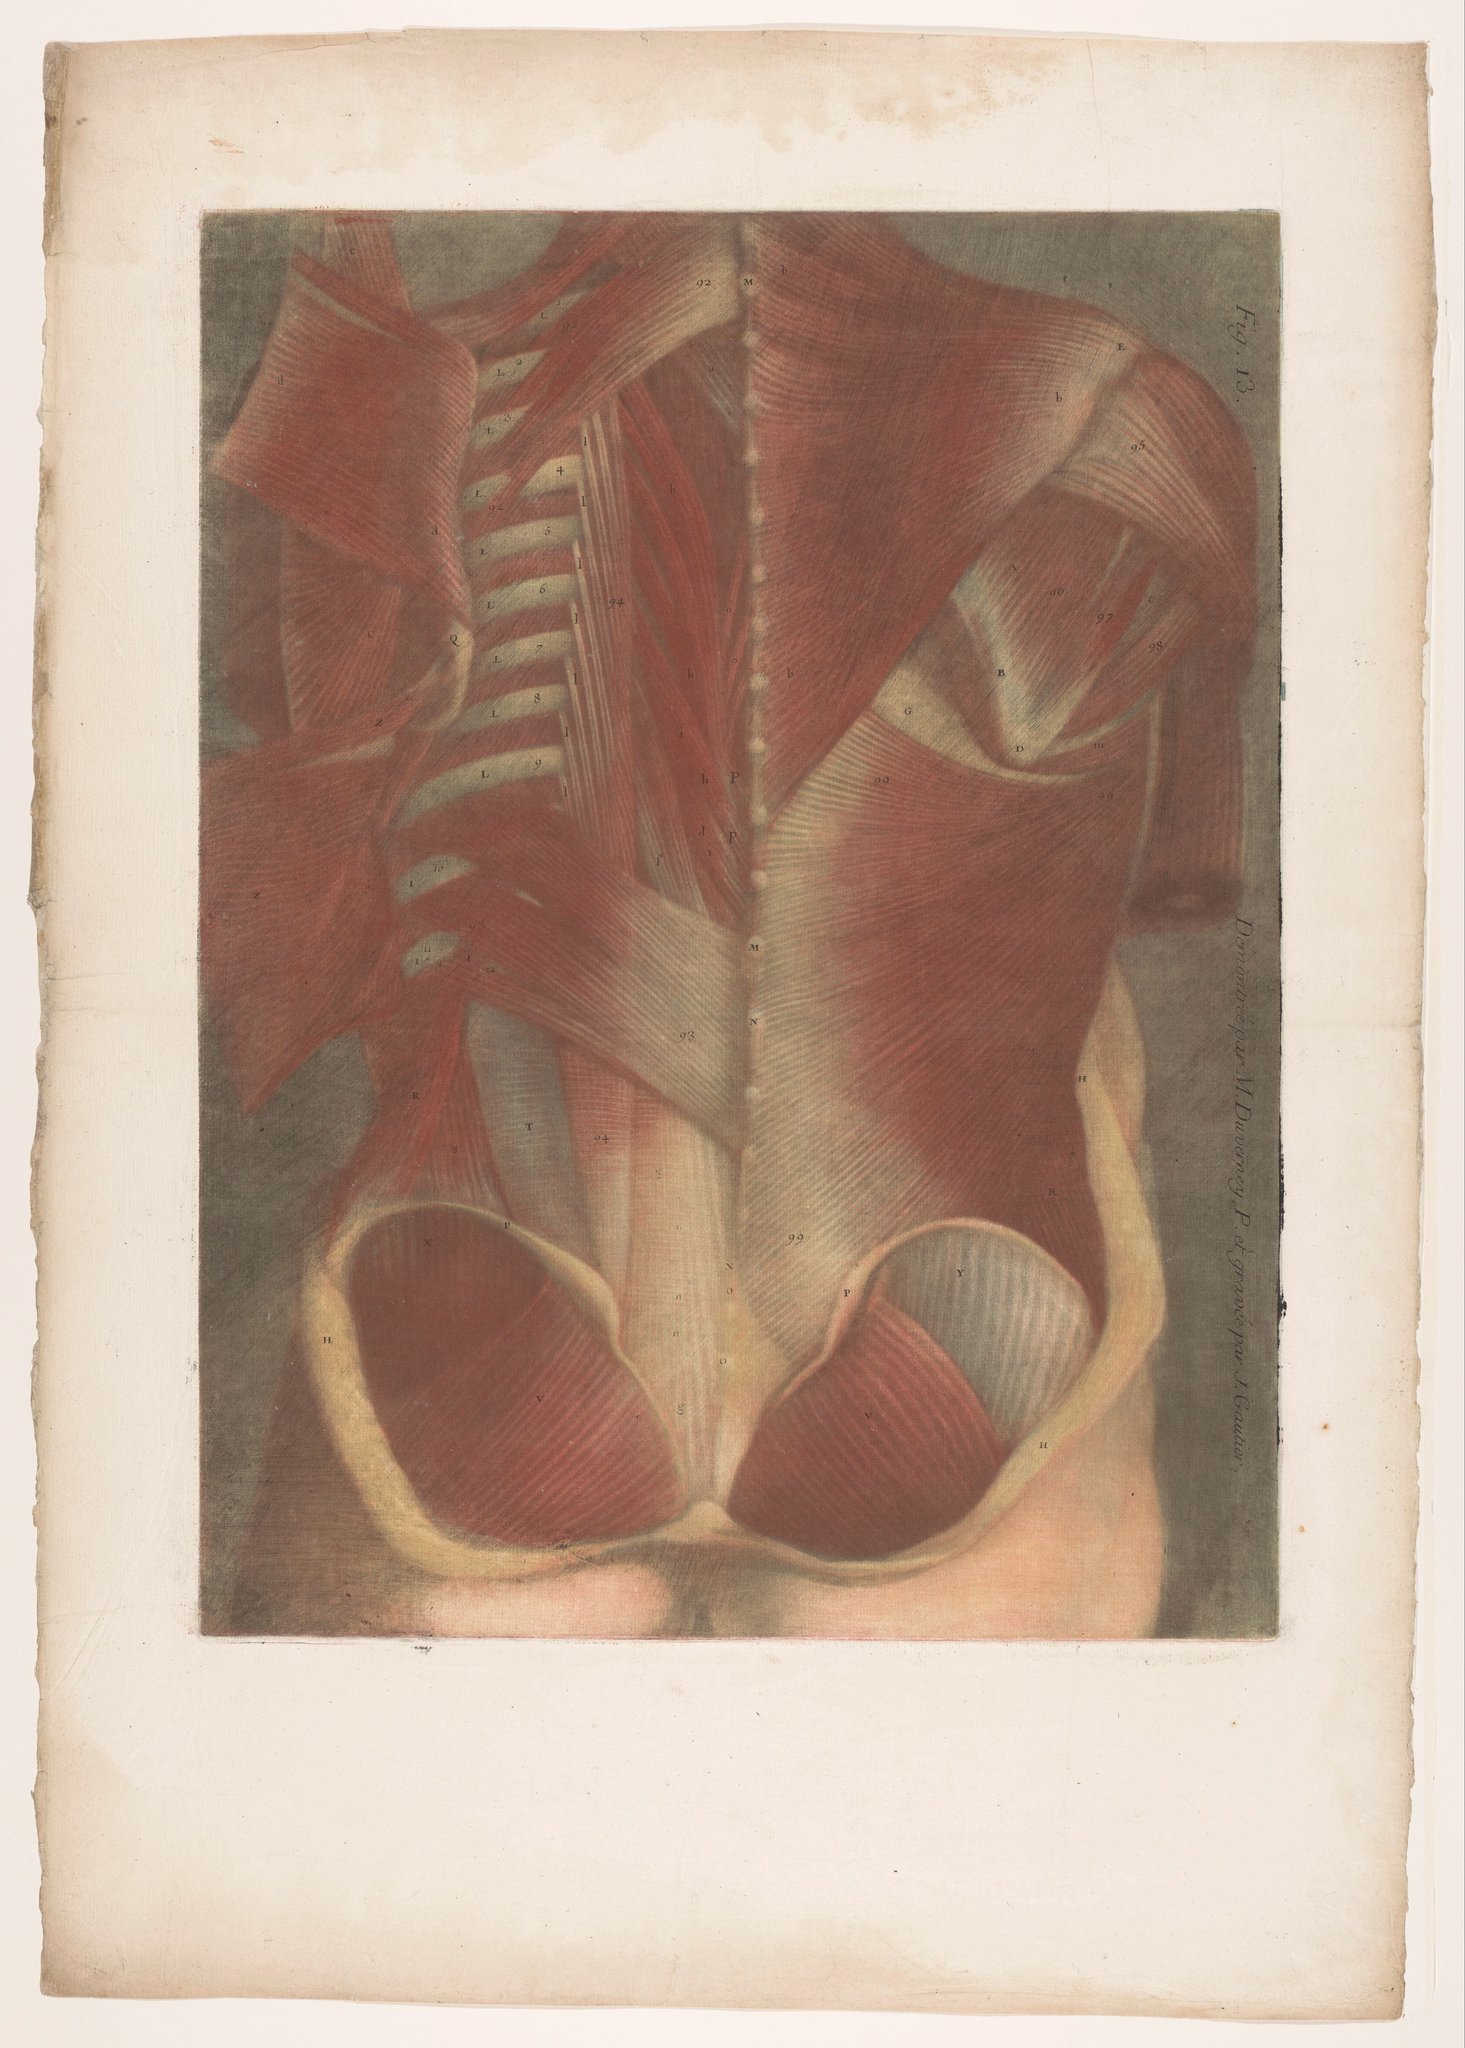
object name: print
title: Myologie complette en couleur et grandeur naturelle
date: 1746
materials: paper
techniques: engraving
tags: anatomical model of the muscles, muscle-man, 'écorché'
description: Prent gebruikt in: Gautier d'Agoty, Jacques Fabien. Myologie complette en couleur et grandeur naturelle (...). Parijs: Jacques Fabien Gautier d'Agoty e.a., 1746, plaat 13.